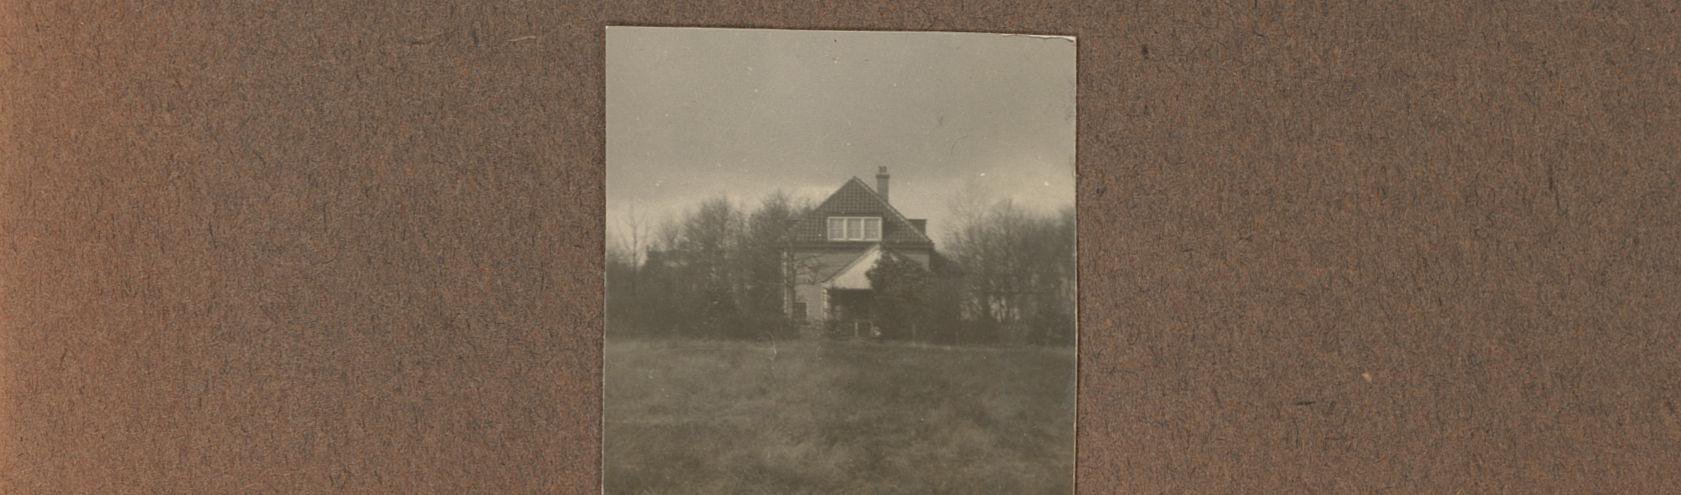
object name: photograph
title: Villa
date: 1900-1915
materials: photographic support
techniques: photography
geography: amsterdam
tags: netherlands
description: Foto op bruin albumblad 52 van familiealbum van Alphons Diepenbrock.